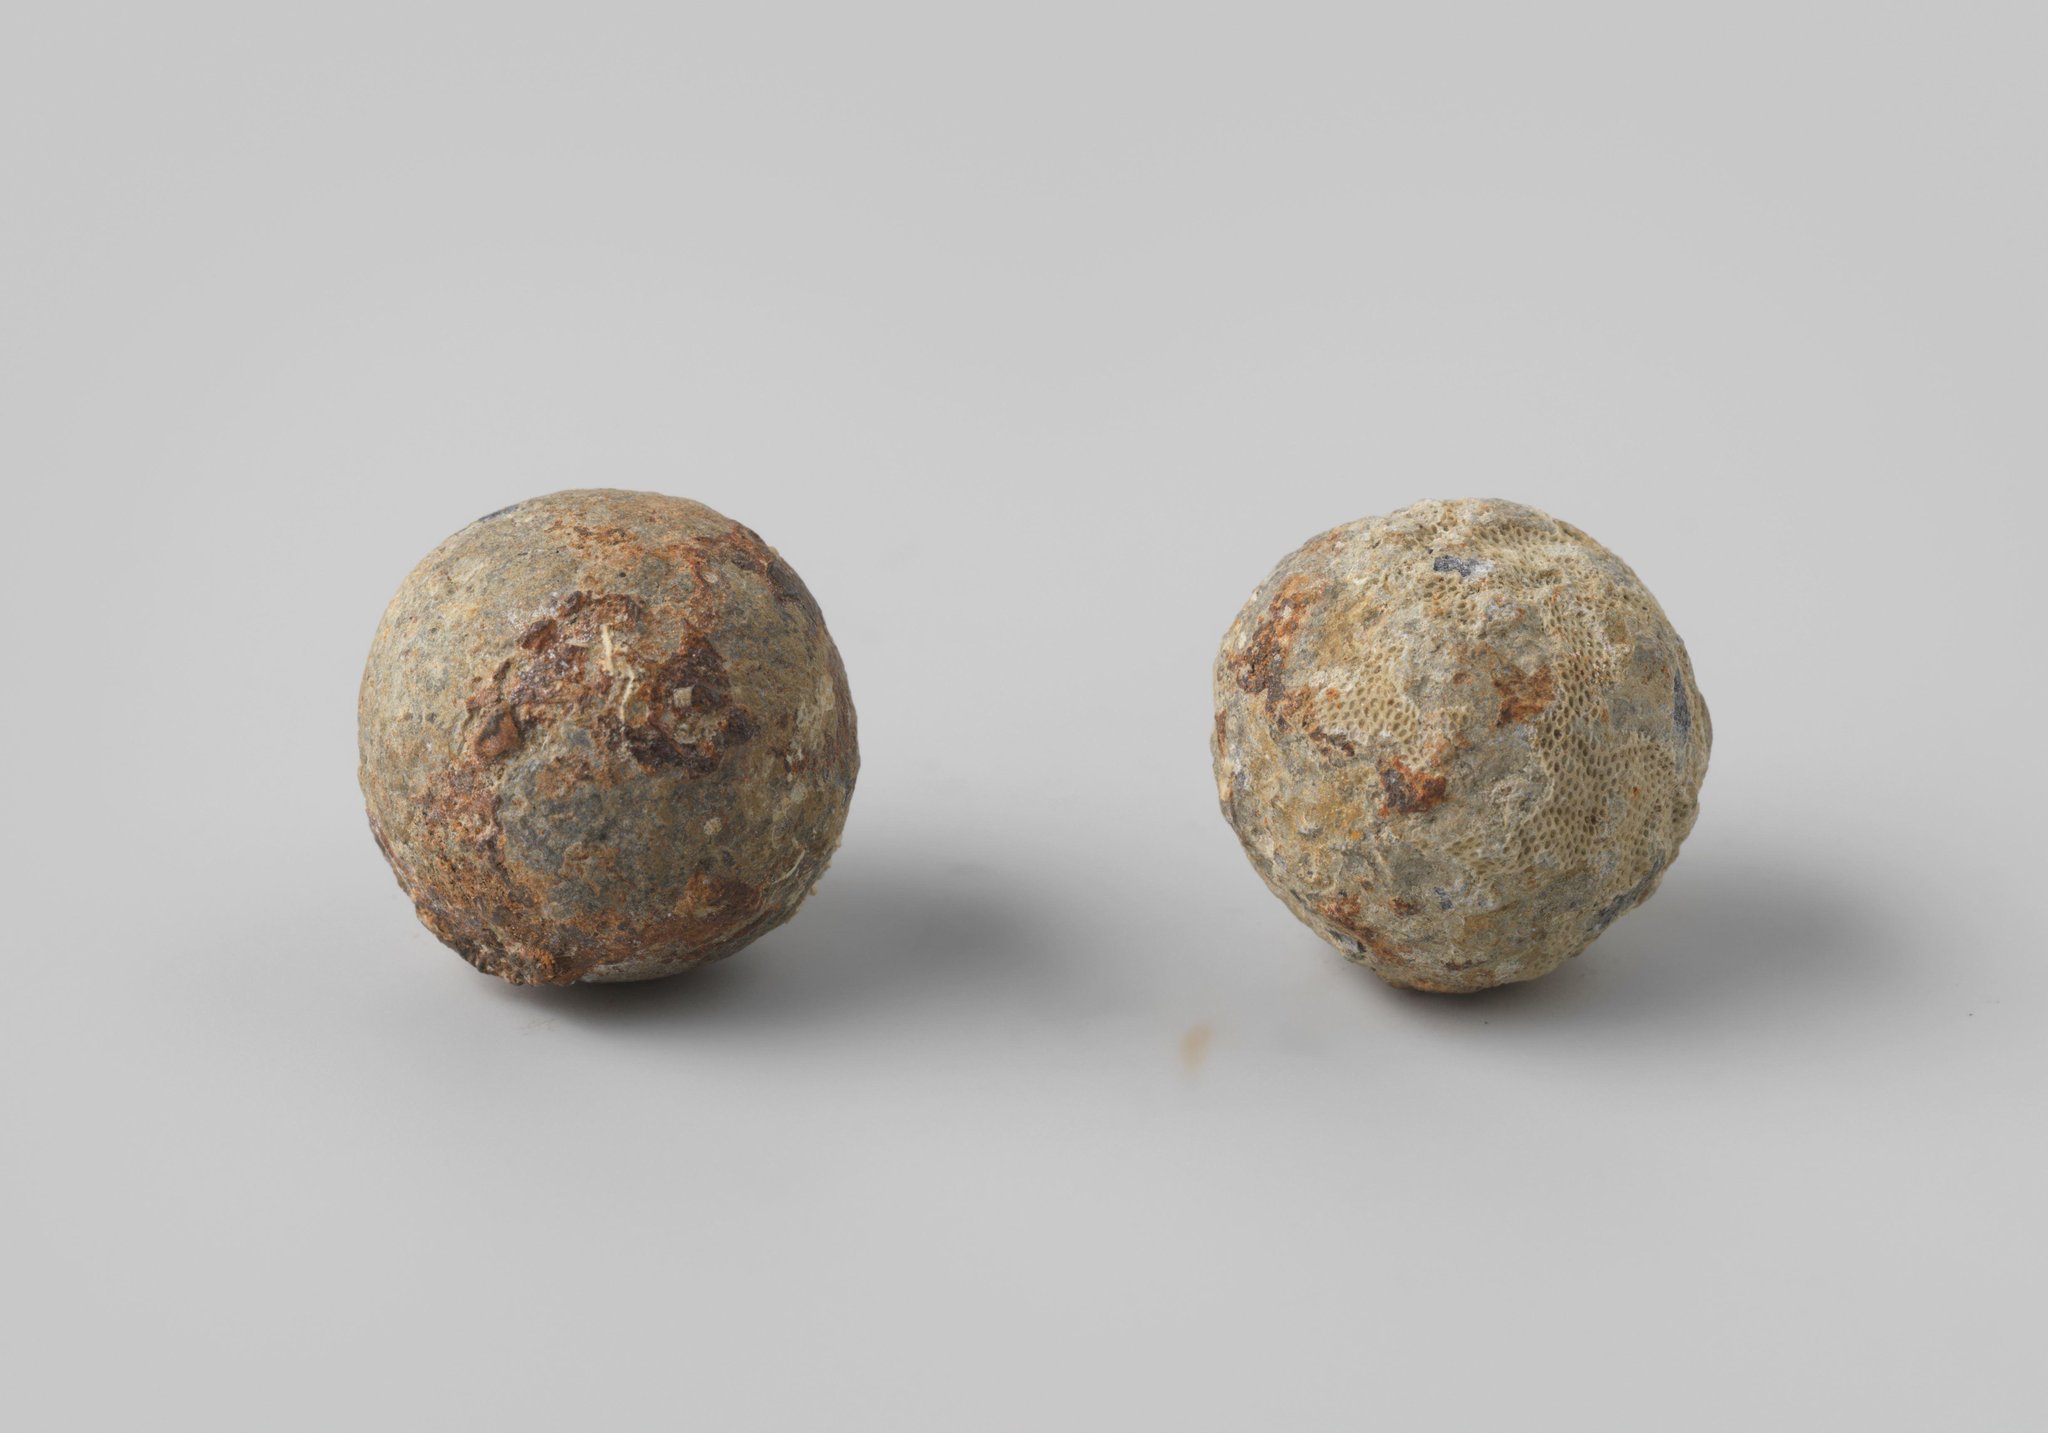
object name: musketkogel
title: Musketkogels uit het wrak van de Oost-Indiëvaarder Hollandia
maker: Anonymous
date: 1700-1743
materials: lead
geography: netherlands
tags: verenigde oostindische compagnie, hollandia (schip), annet